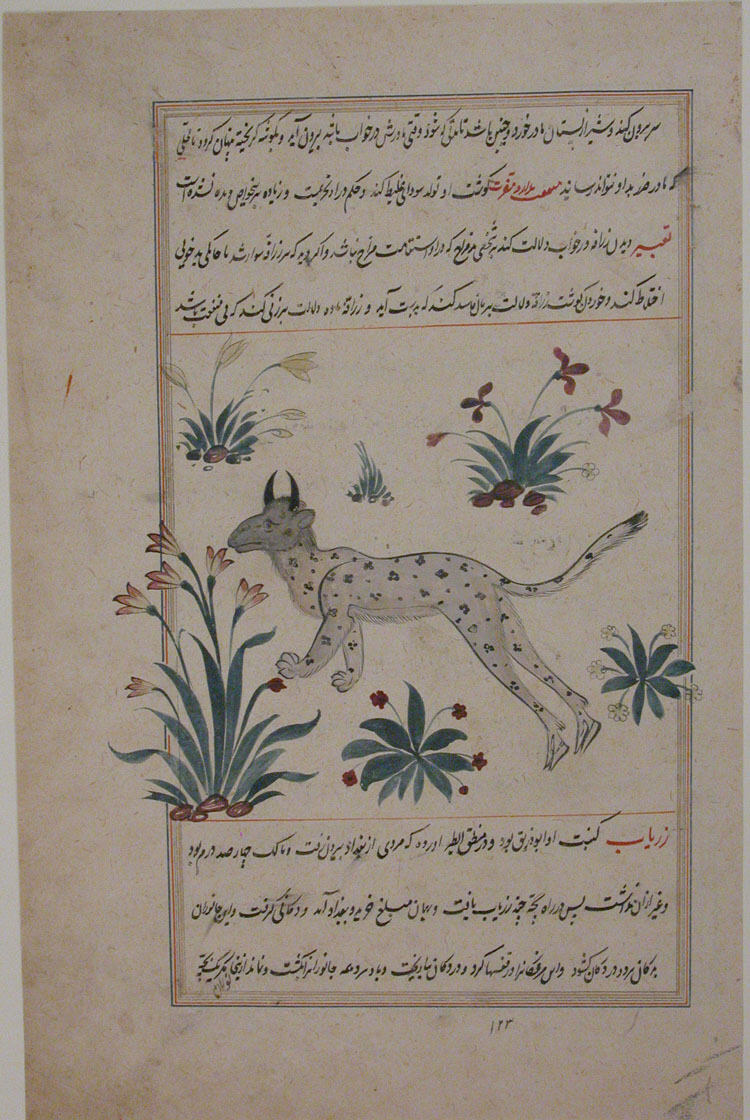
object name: folio from an illustrated manuscript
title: Folio from a Bestiary and Herbal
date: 1600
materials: gold, paper, watercolor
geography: iran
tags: animals,flowers,leaves